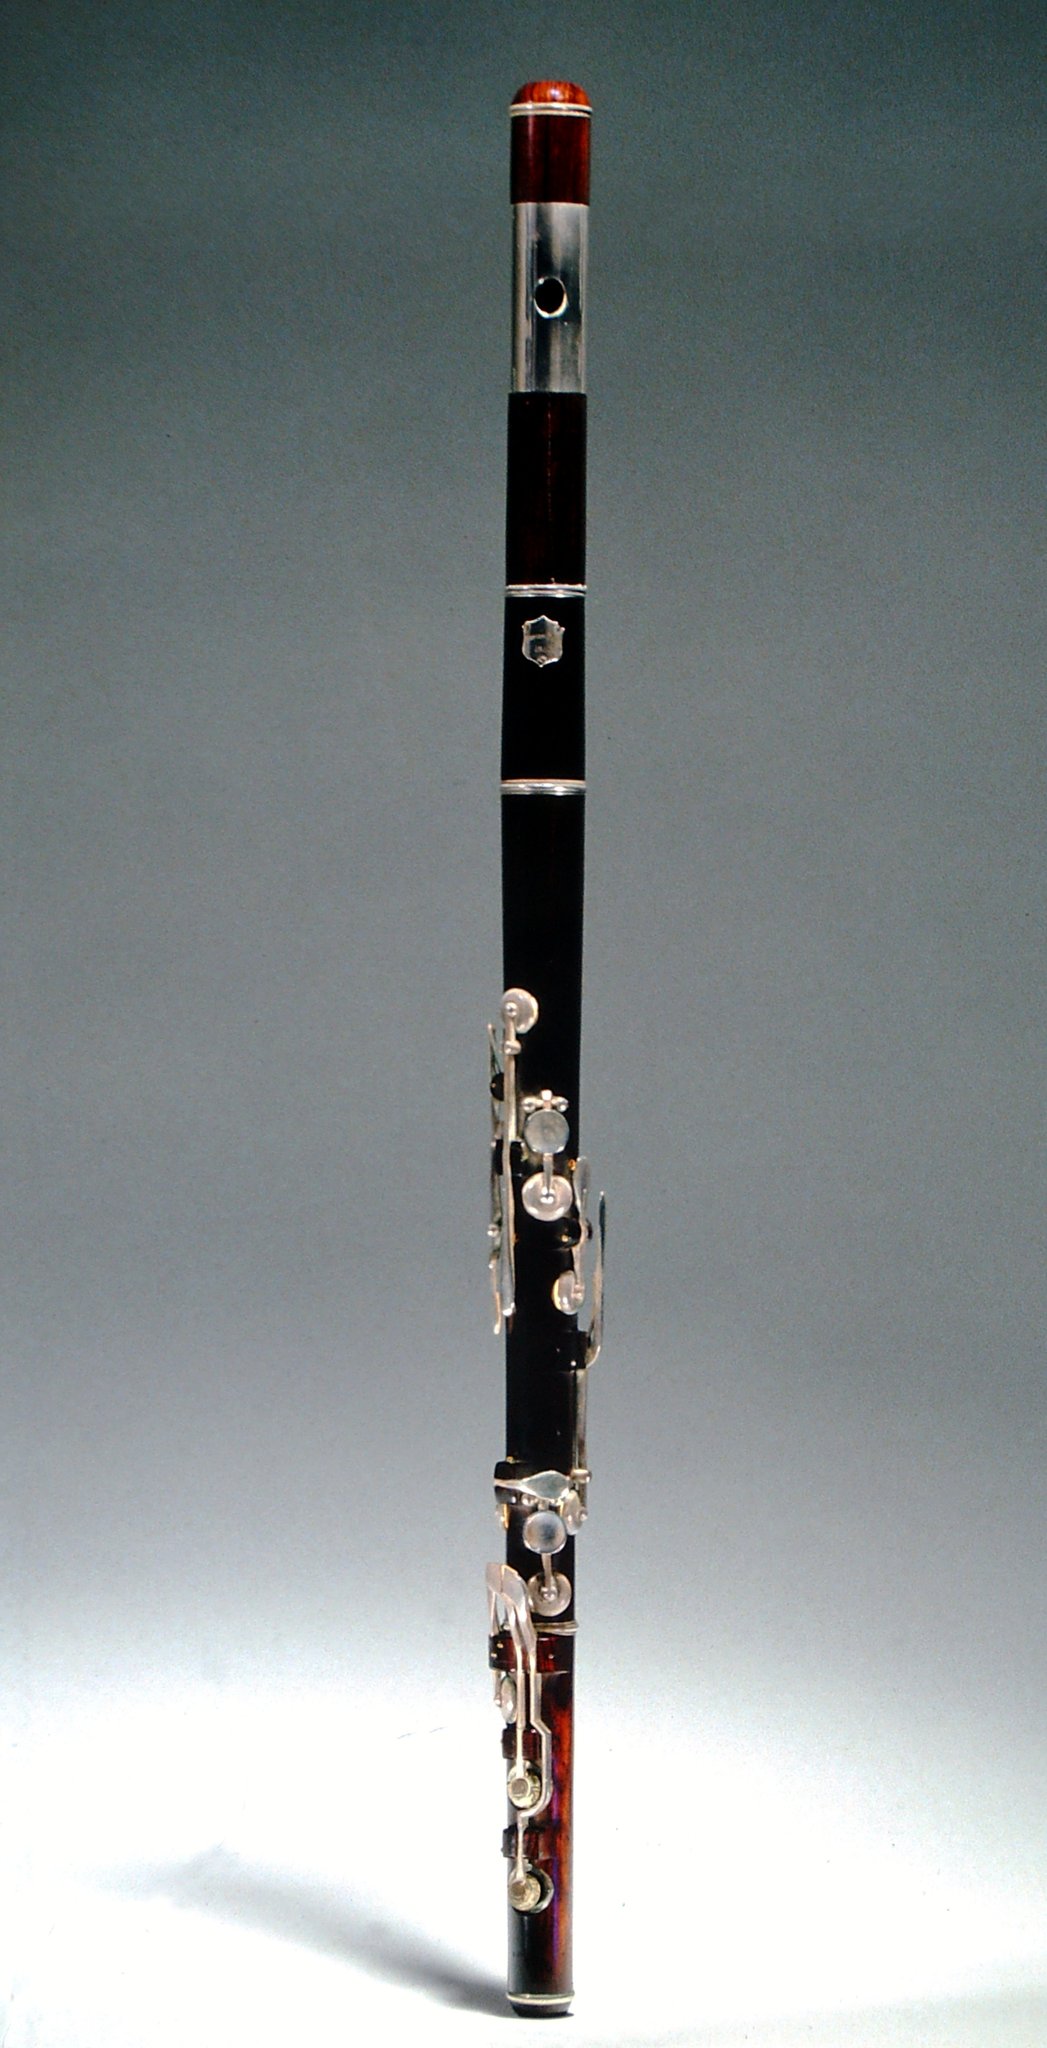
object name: transverse flute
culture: american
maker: hugh cottier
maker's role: maker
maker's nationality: american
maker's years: 1840-1860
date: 1850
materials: metal, wood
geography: united states